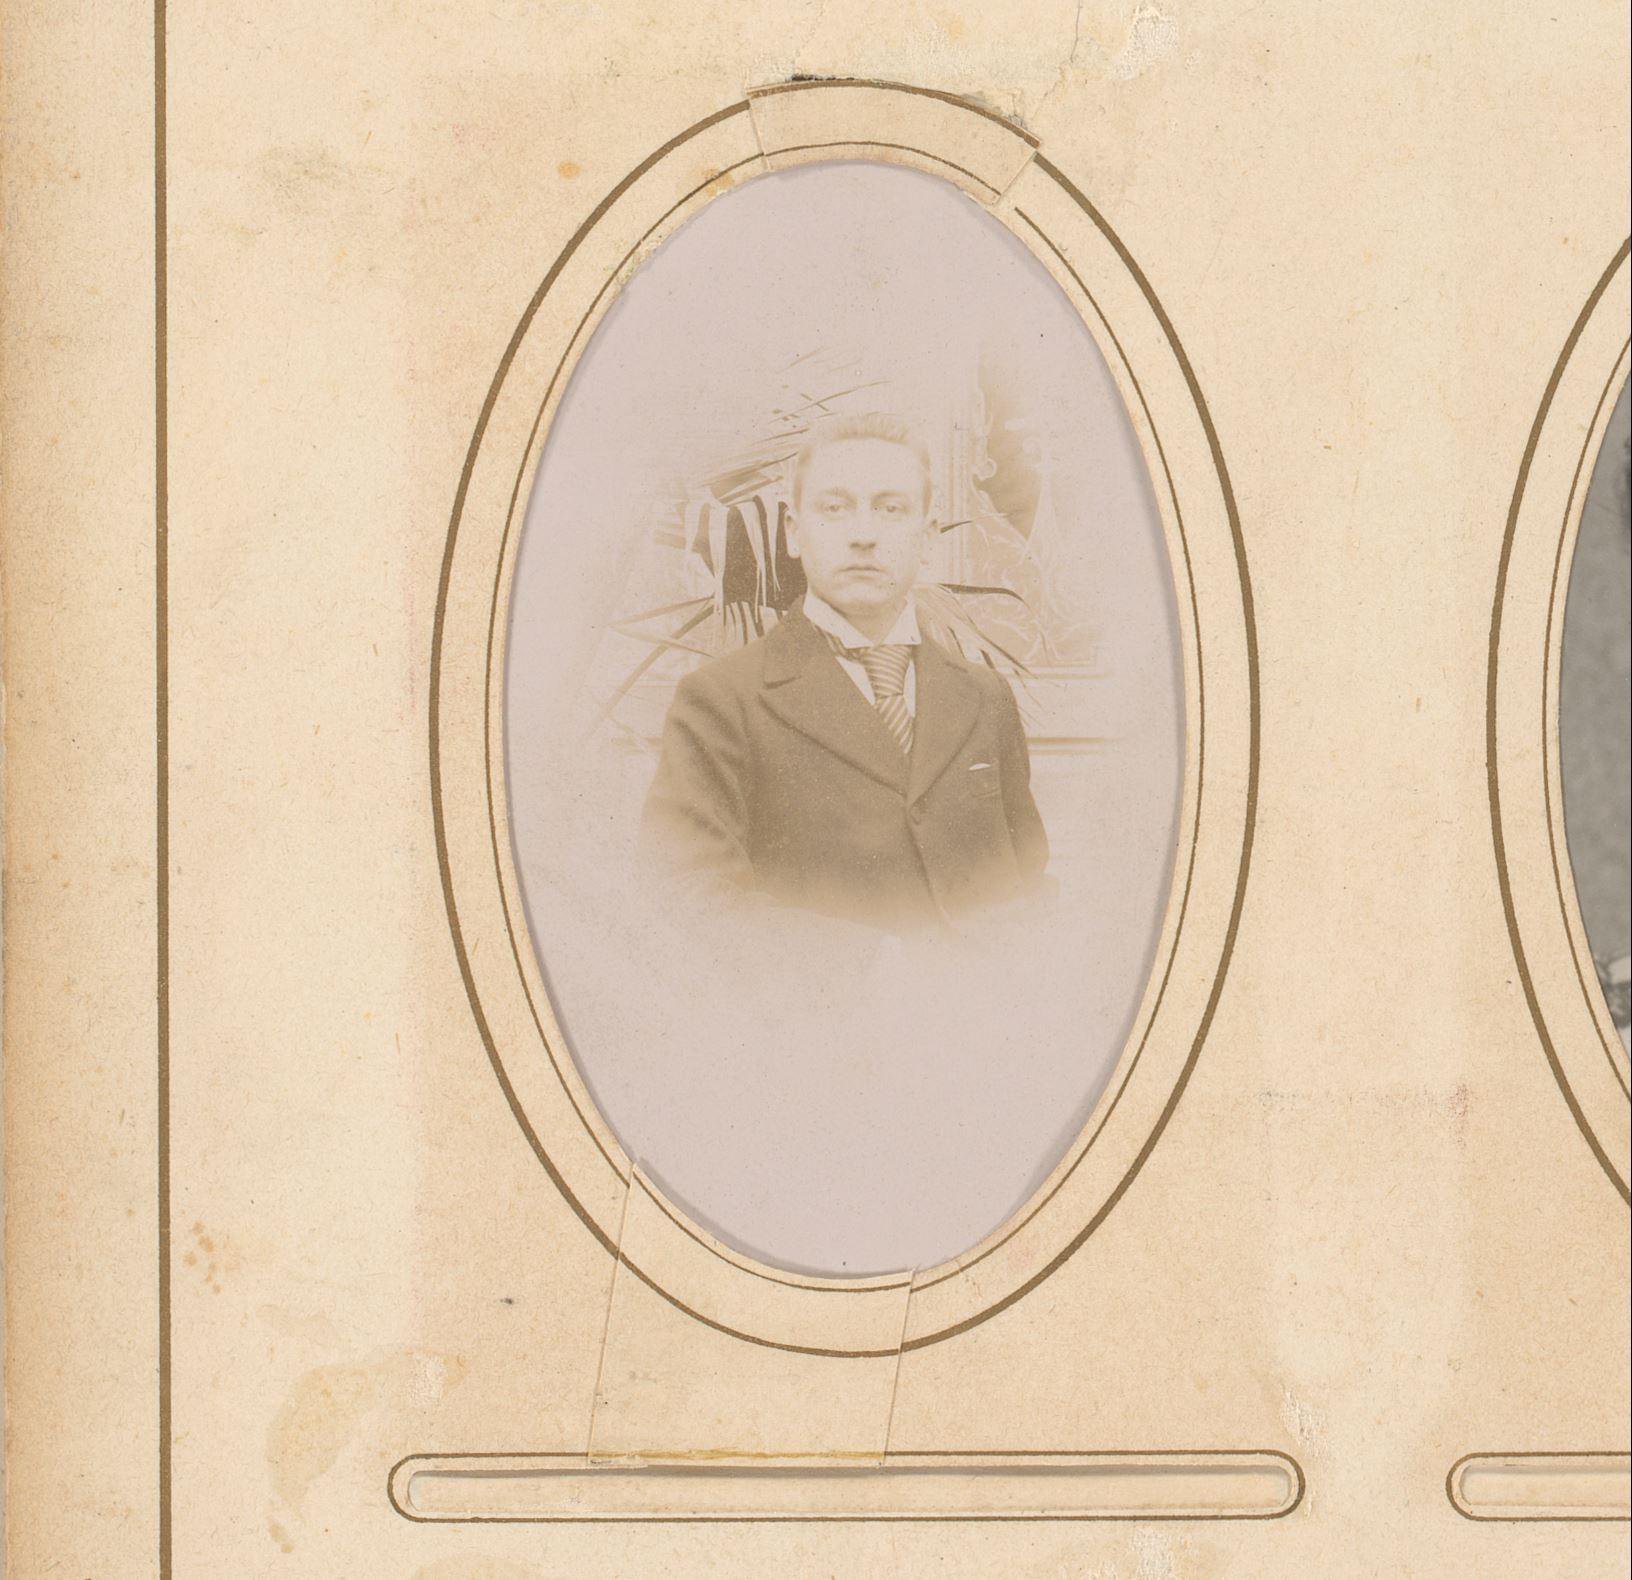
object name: photograph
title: Portret van een man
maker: Anonymous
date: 1897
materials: cardboard, photographic support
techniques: collodion silver print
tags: adult man, historical persons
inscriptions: inscription: ‘Moors 1897’